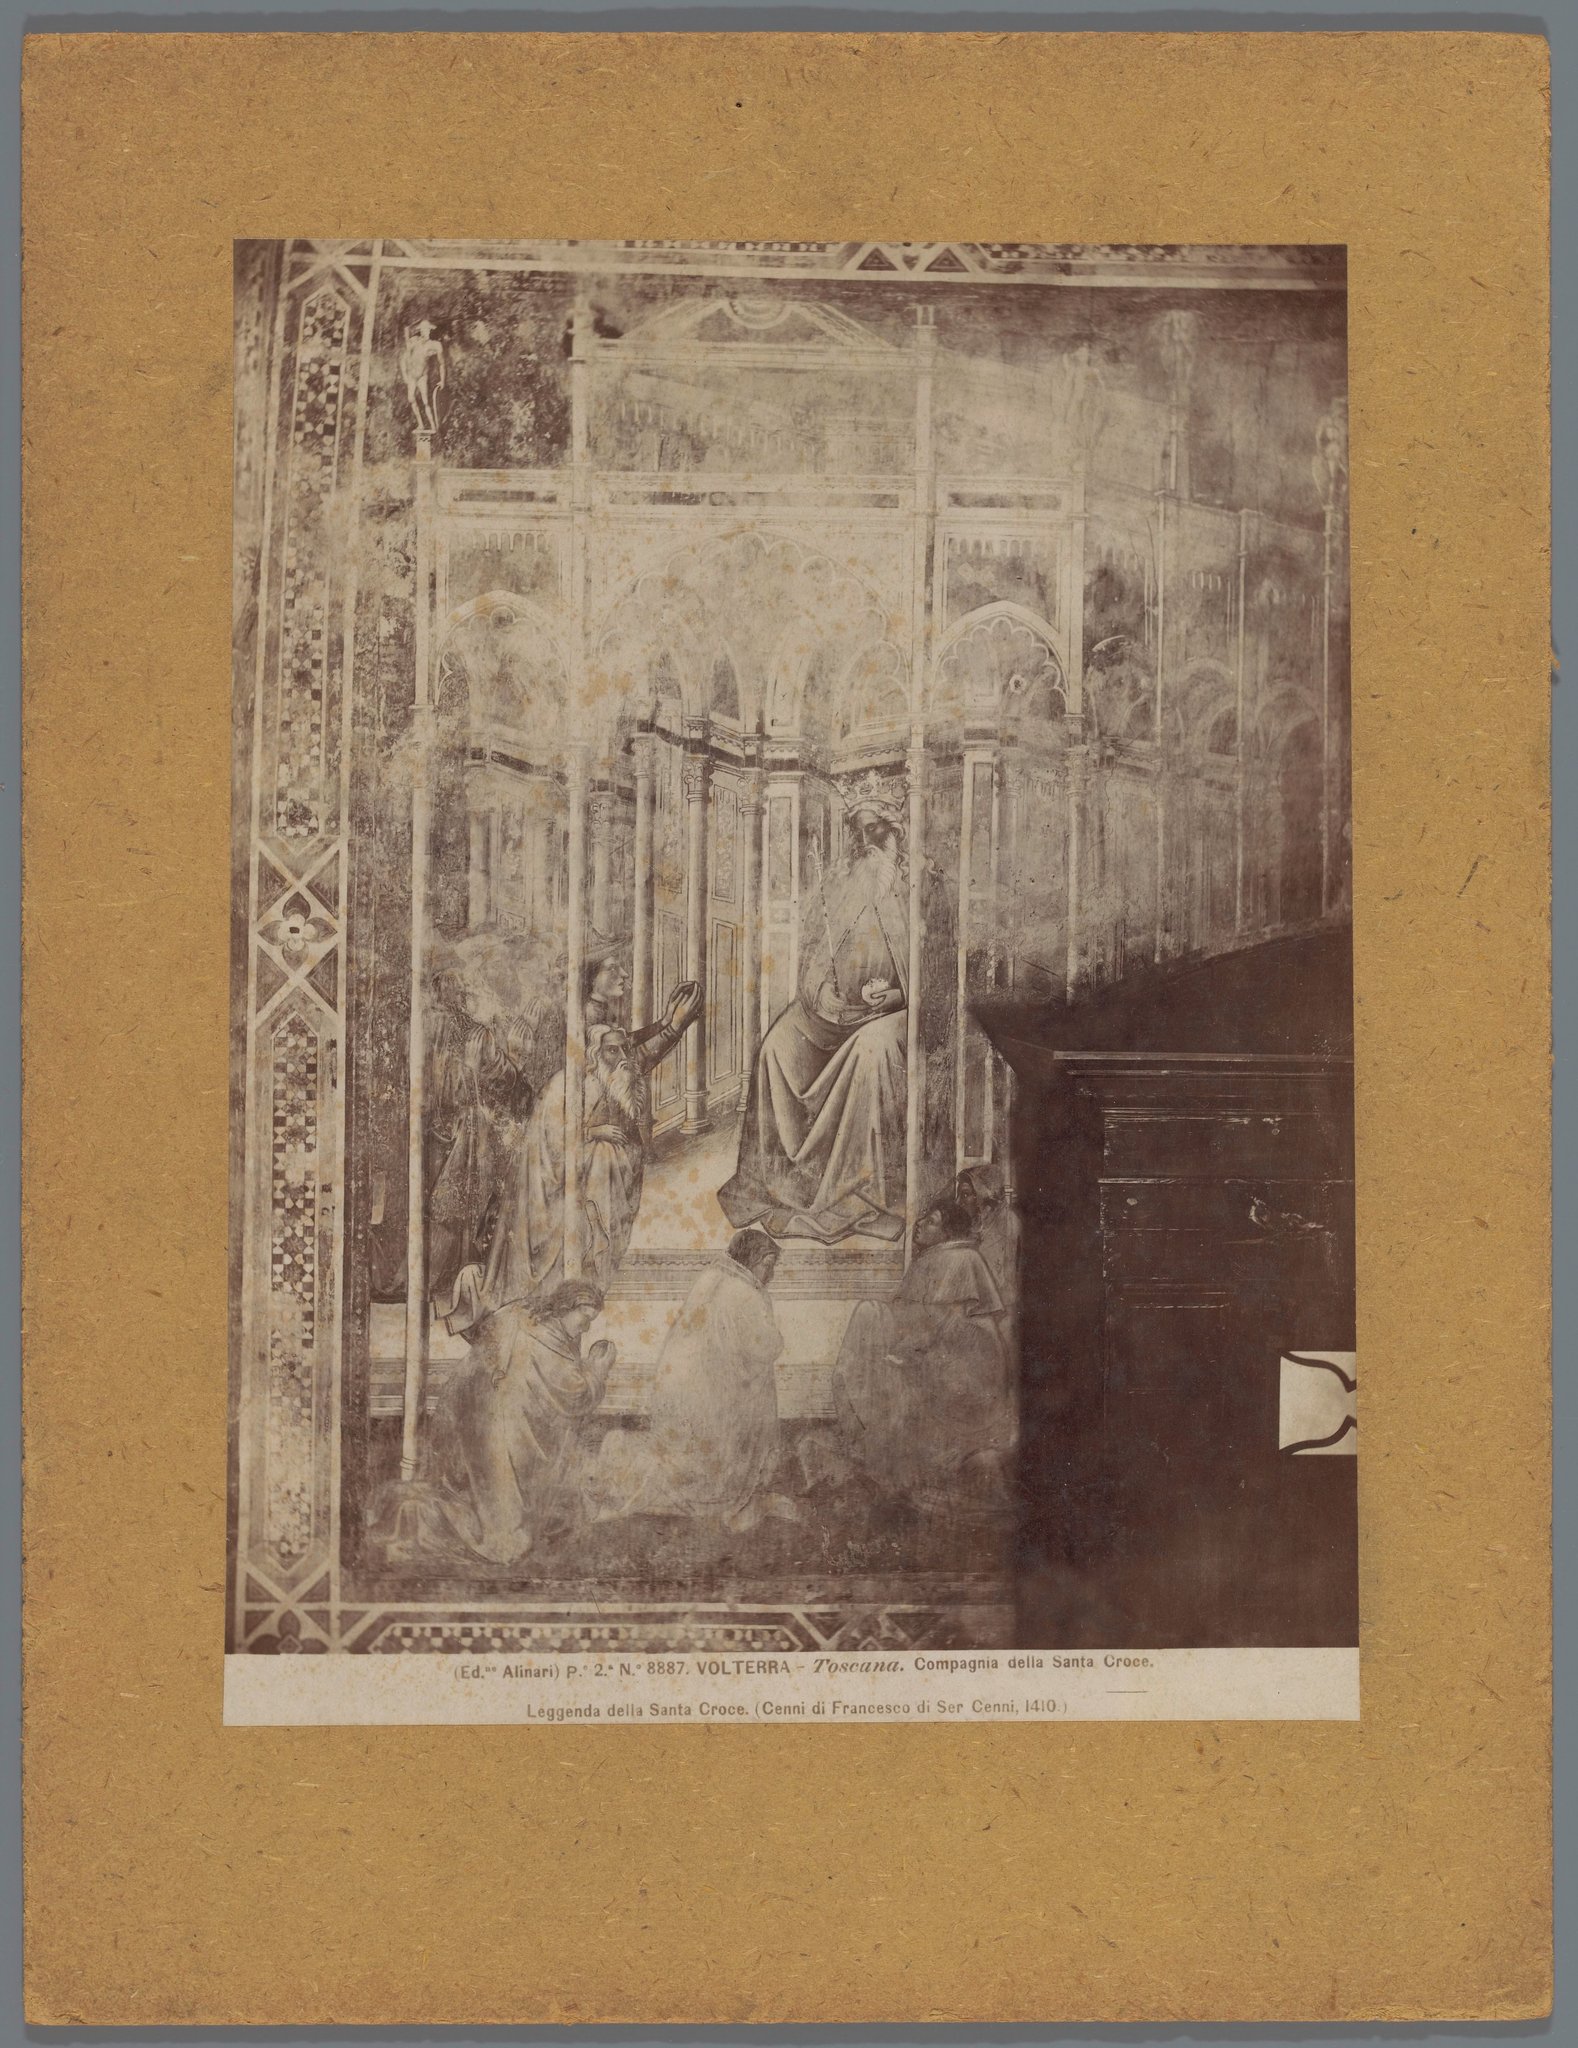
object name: photograph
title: VOLTERRA - Toscana. Compagnia della Santa Croce. Leggenda della Santa Croce. (Cenni di Francesco di ser Cenni, 1410.)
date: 1875-1900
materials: cardboard, photographic support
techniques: albumen print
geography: chiesa di san francesco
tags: painting (including book-illumination, miniature-painting) (+ plaster ~ arts), legend of the true cross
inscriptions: number: ‘P.e 2.a N.o 8887.’, collector's mark: Lugt 3937